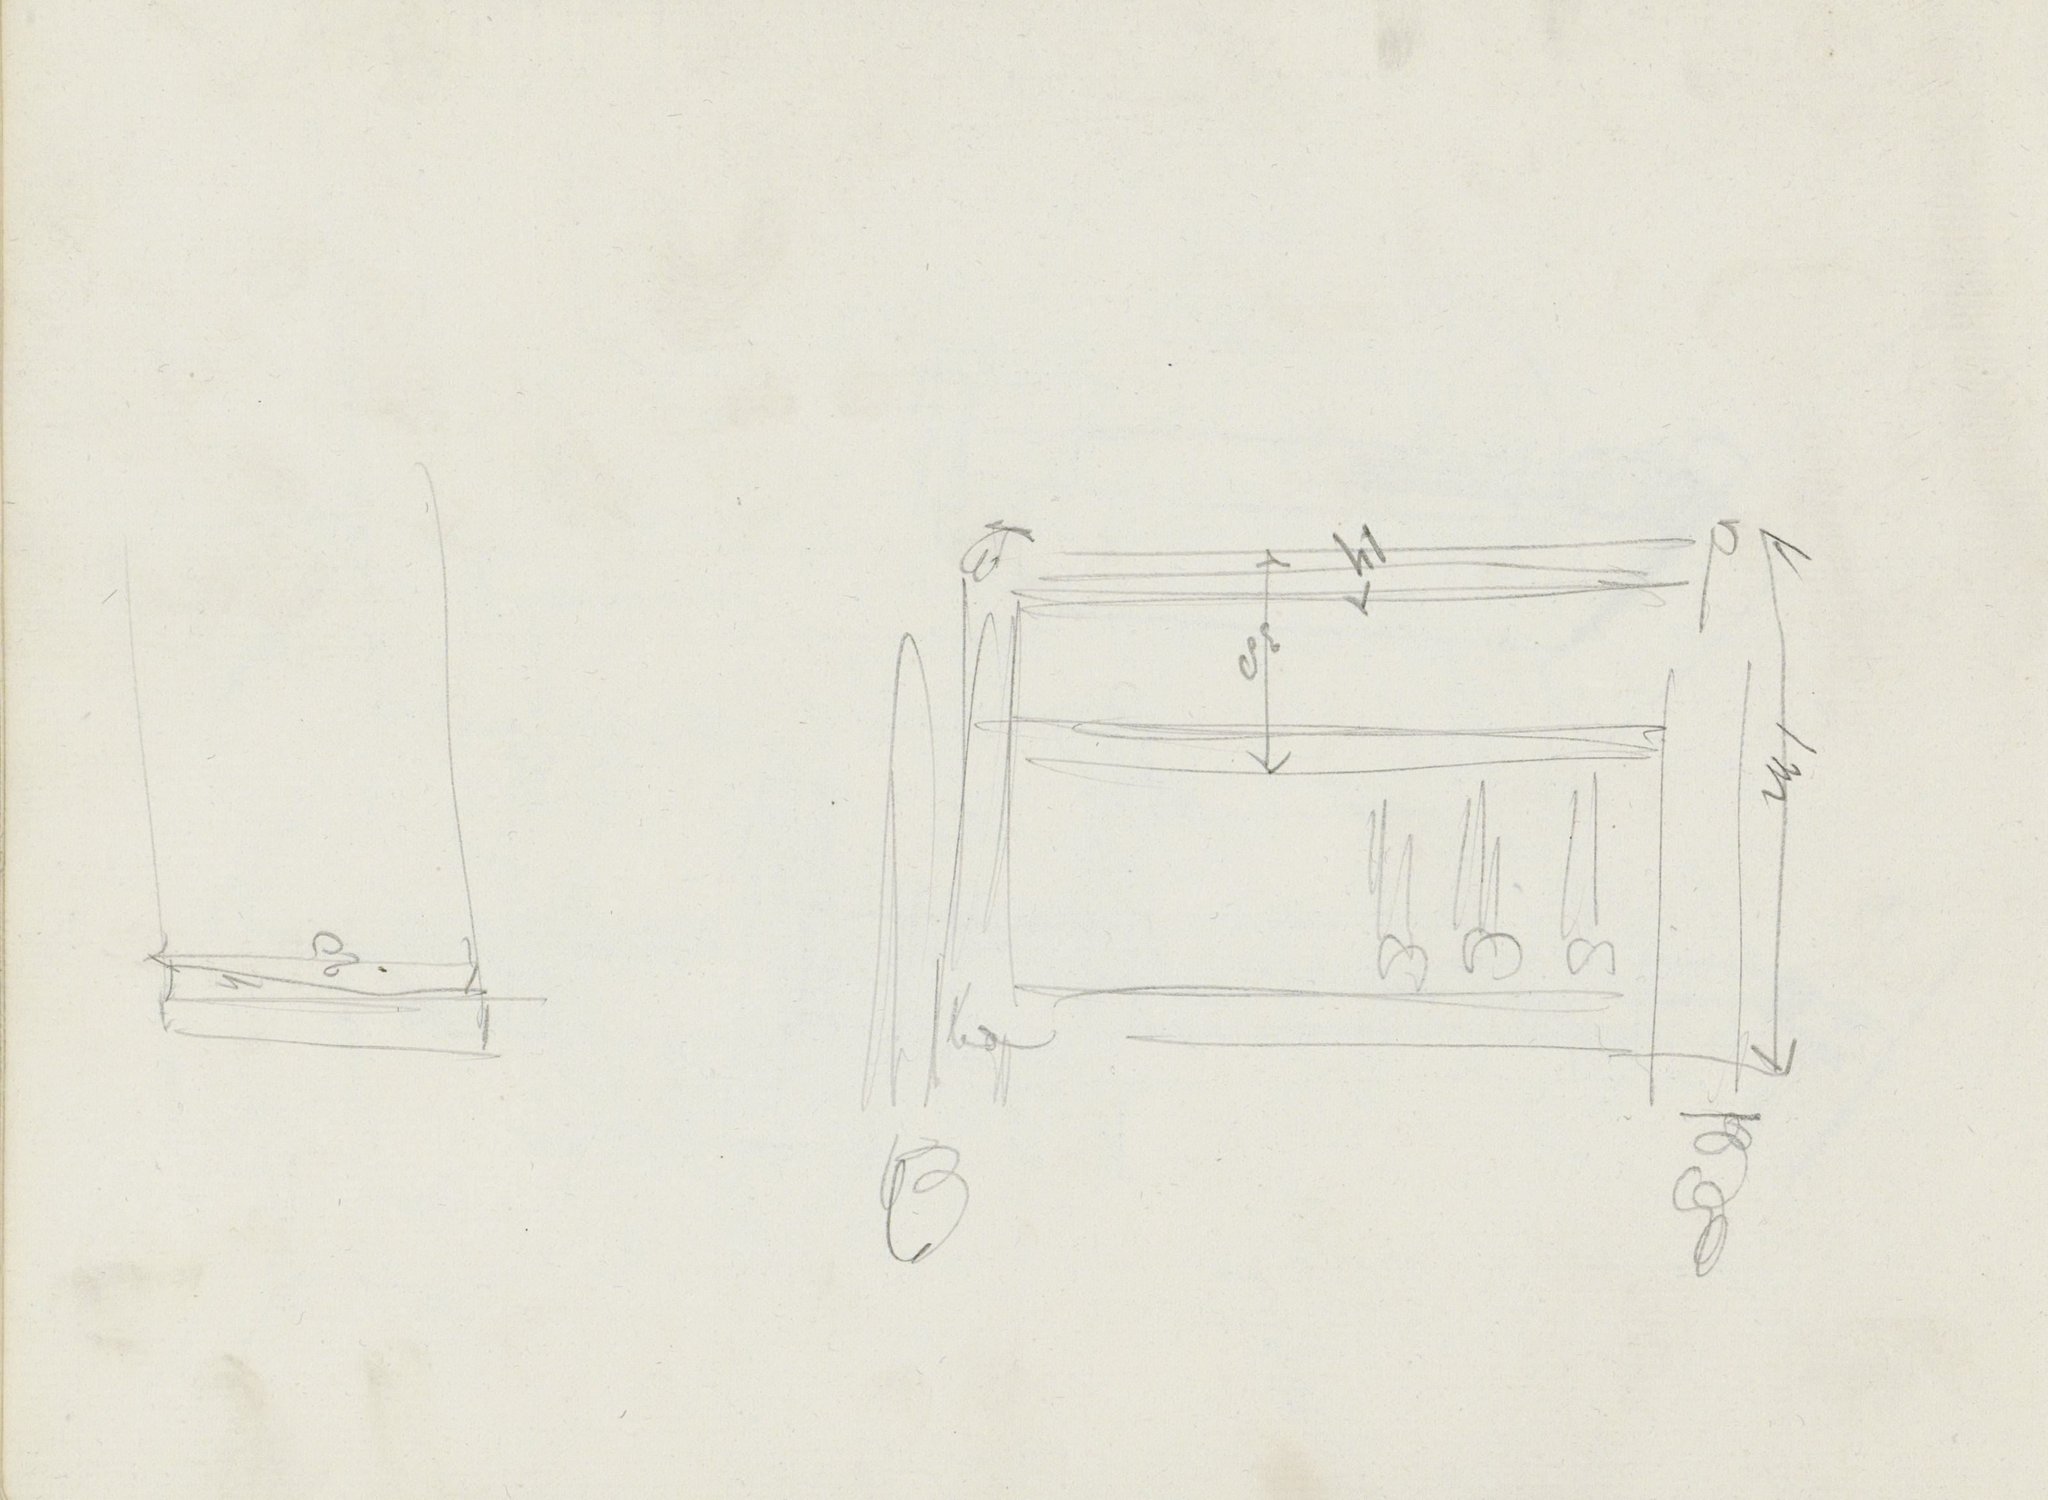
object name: sketchbook leaf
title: Ontwerp voor een meubel of wand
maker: carel adolph lion cachet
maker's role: draughtsman, print maker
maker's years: 1864-1945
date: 1905-1910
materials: paper, pencil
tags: furniture and household effects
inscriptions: annotation: ‘[...]’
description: Blad 15 verso uit een schetsboek met 27 bladen.